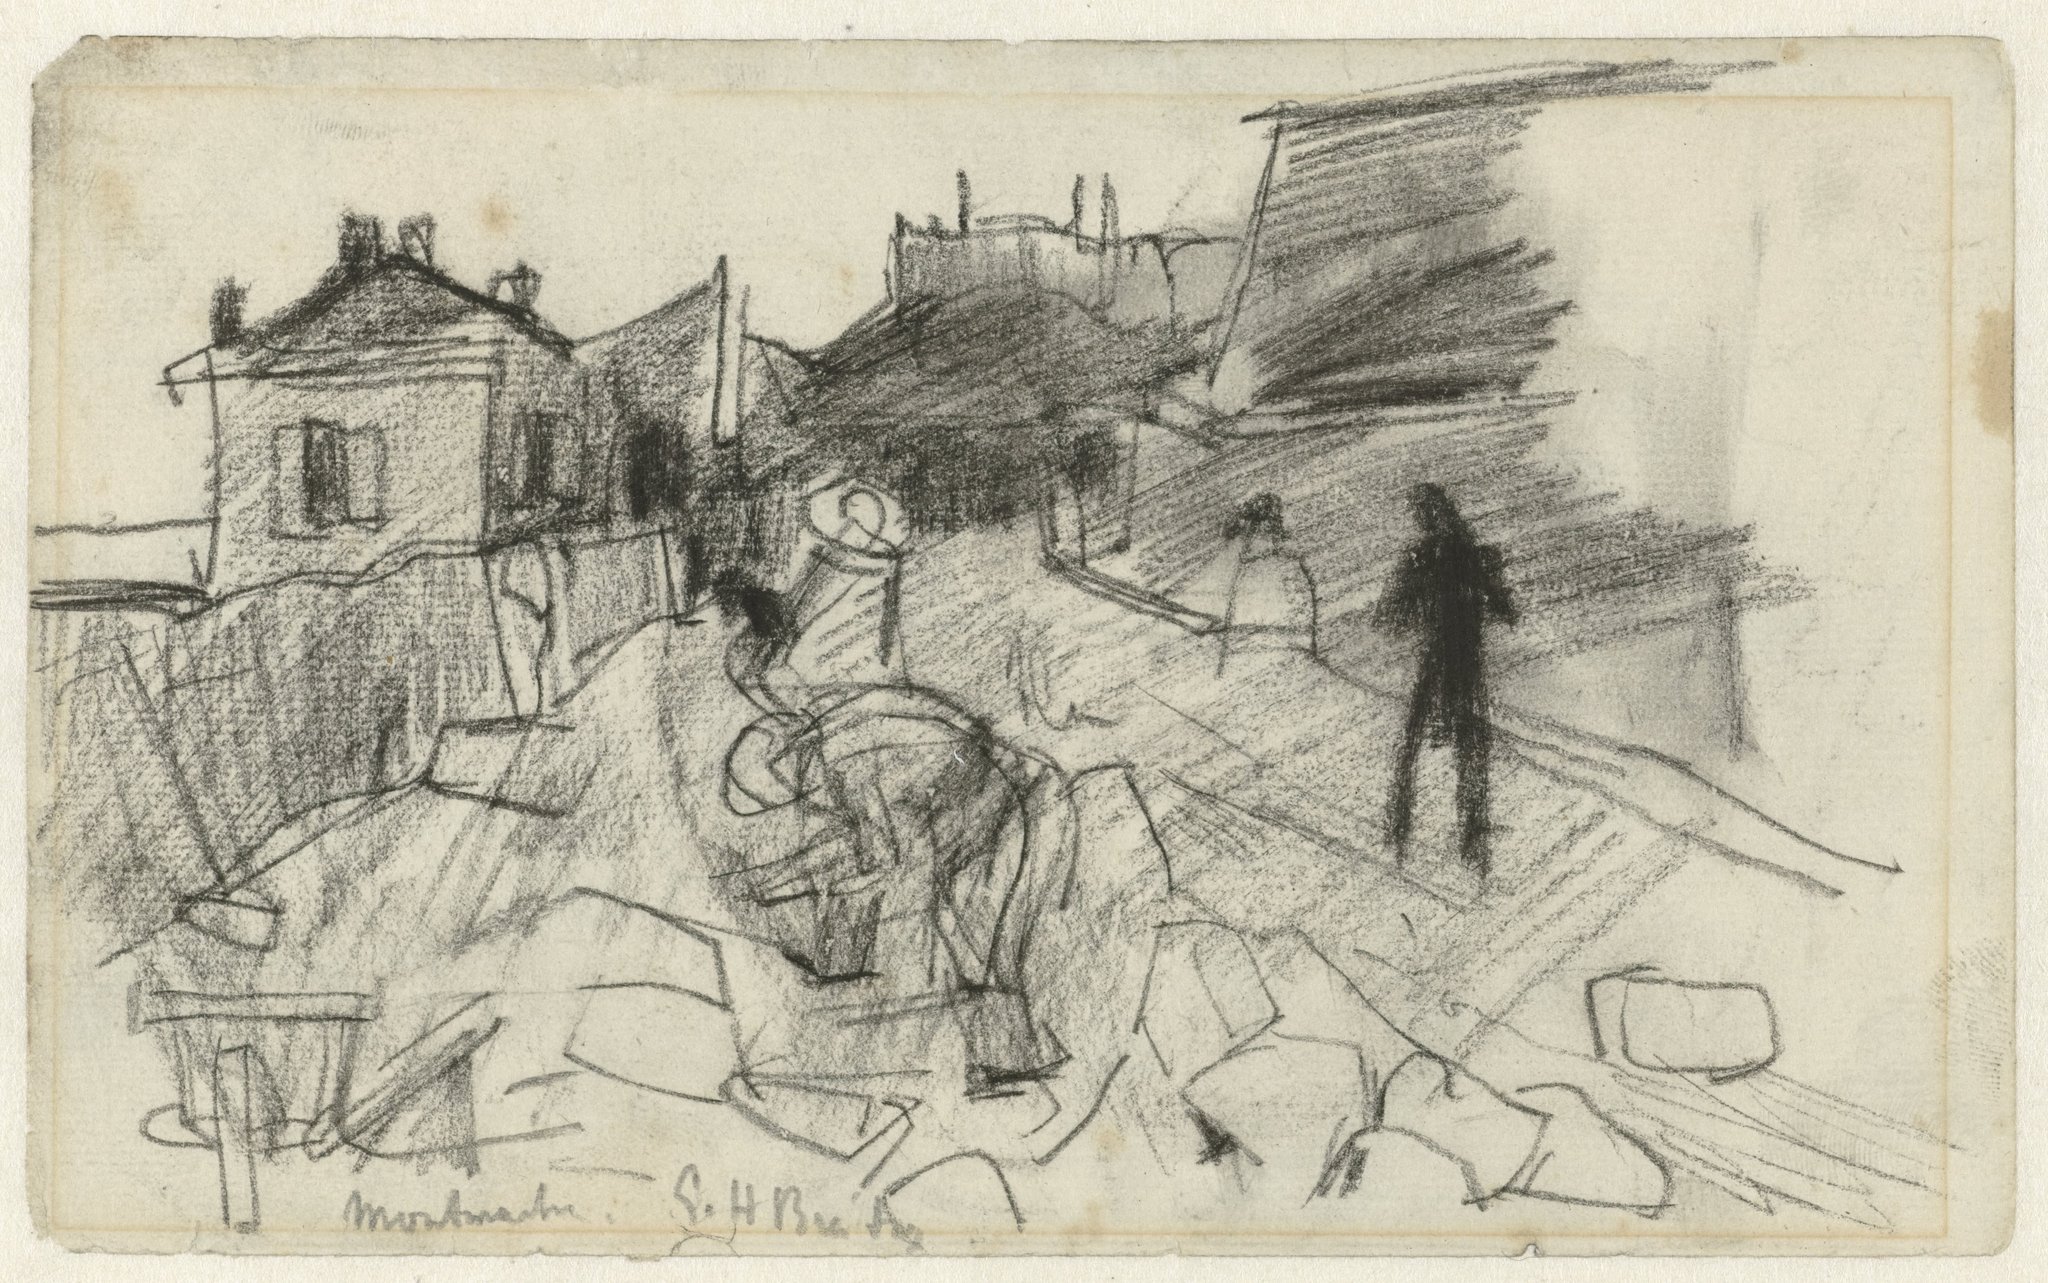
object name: drawing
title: Montmartre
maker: george hendrik breitner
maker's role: draughtsman, painter, print maker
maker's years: 1857-1923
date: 1867-1923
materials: chalk, paper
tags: street